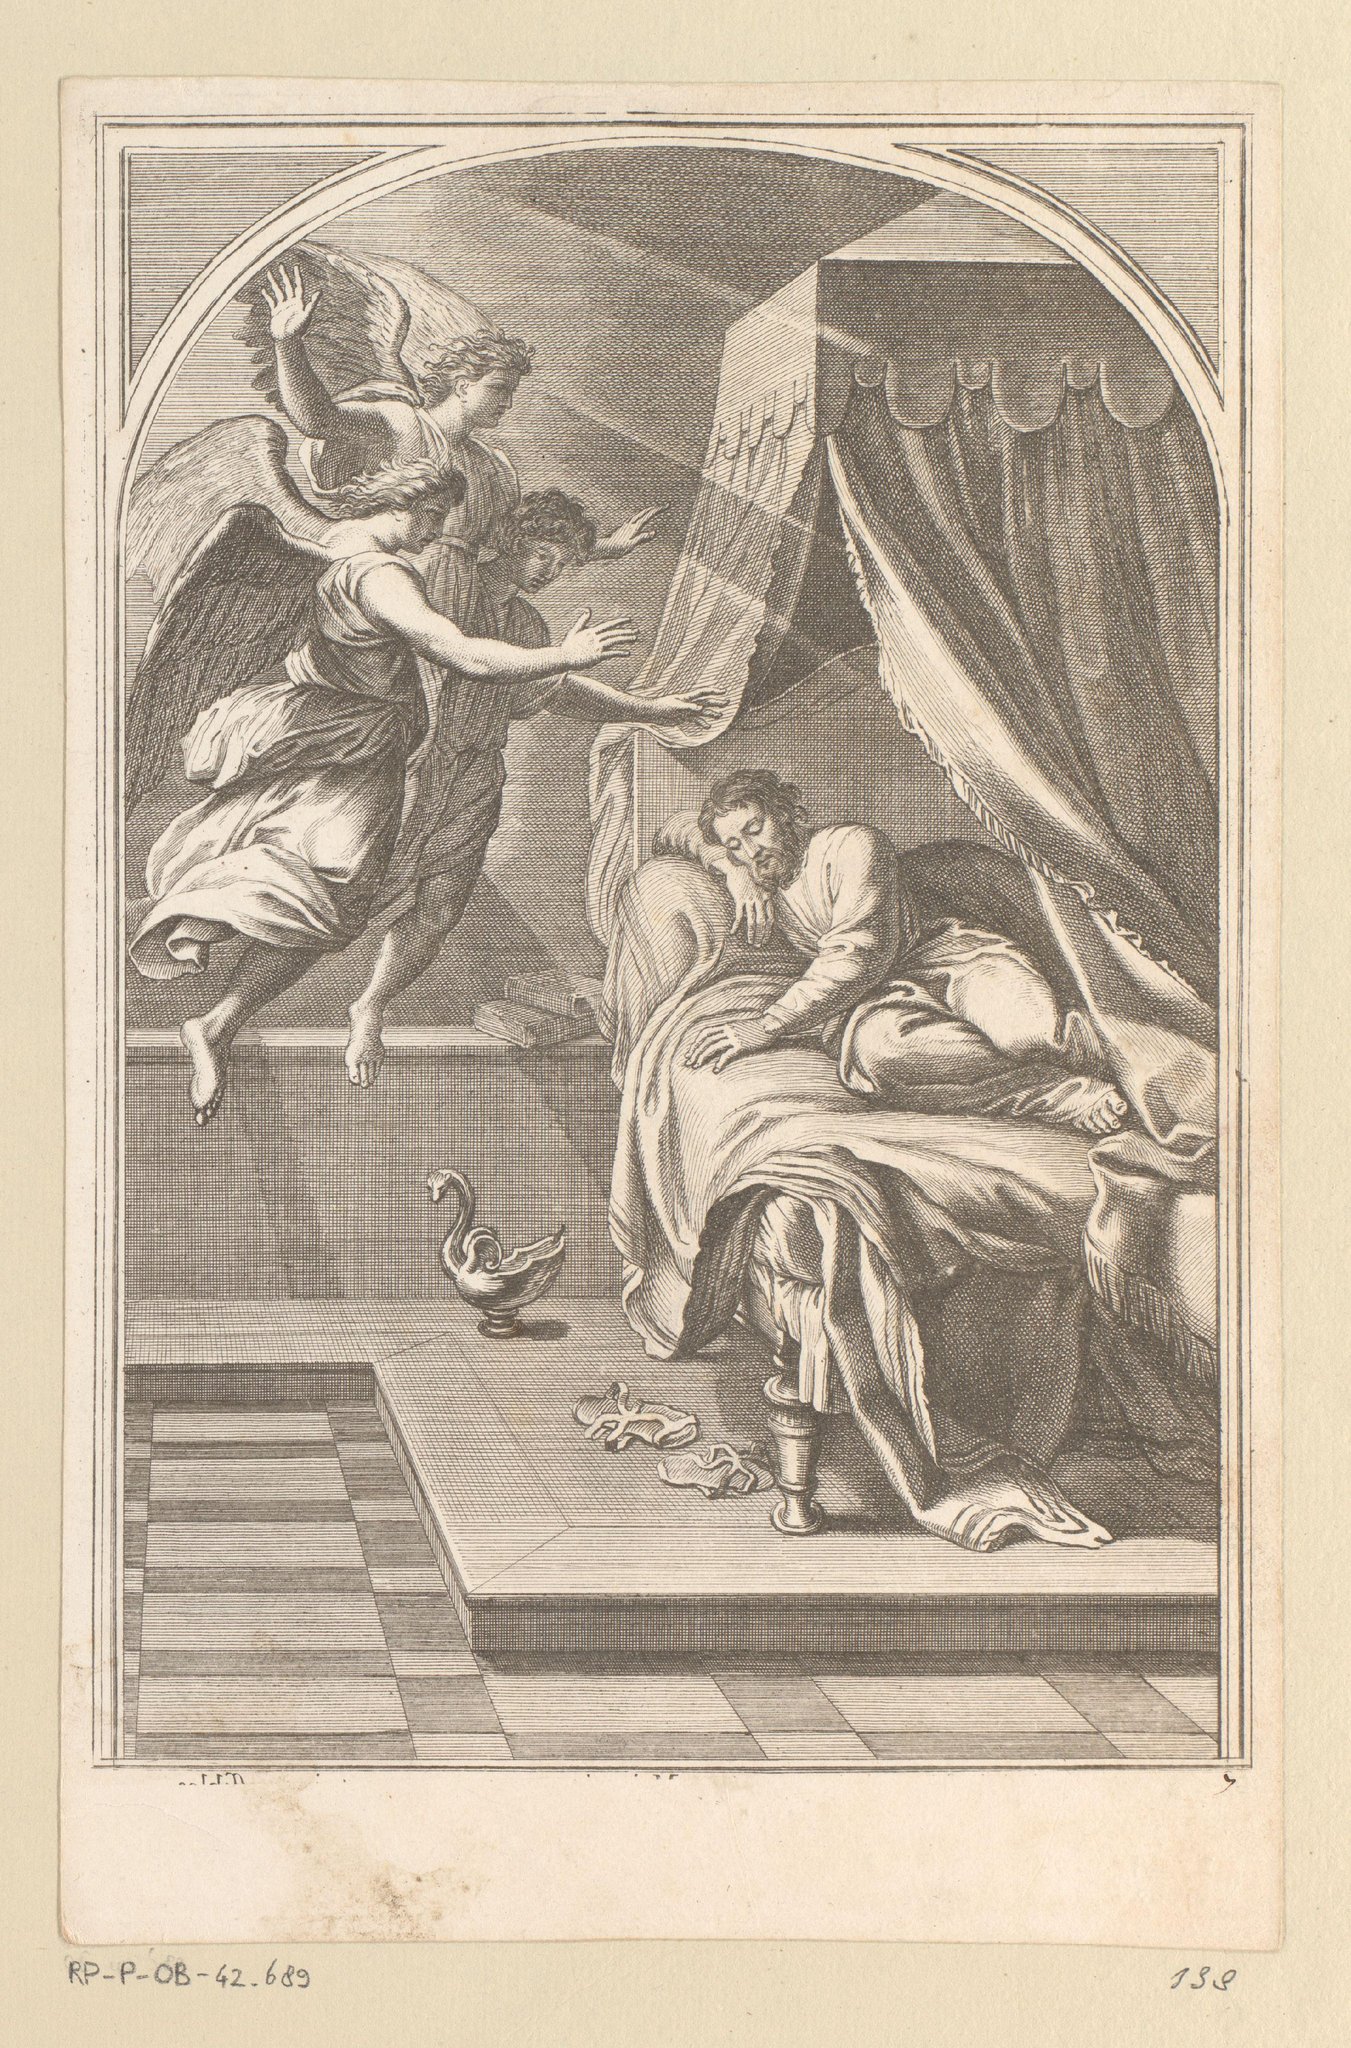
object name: print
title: Engelen verschijnen in een droom aan de Heilige Bruno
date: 1623-1676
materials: paper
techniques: printmaking, engraving, etching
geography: paris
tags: the founder of the order of the carthusians, bruno; possible attributes: cross, finger at lips, lily, mitre at his feet, olive-branch, ray of light, skull, (seven) star(s)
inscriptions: collector's mark: Lugt 2165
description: Maakt deel uit van een serie met 24 prenten (inclusief twee titelprenten), naar schilderijen door Lesueur vervaardigd tussen 1645-1648 voor de Chartreuse de Paris. De serie is getiteld: La vie de St. Bruno fondateur de l'Ordre des Chartreux peinte au cloistre de la Chartreuse de Paris par Eustache Le Sueur.